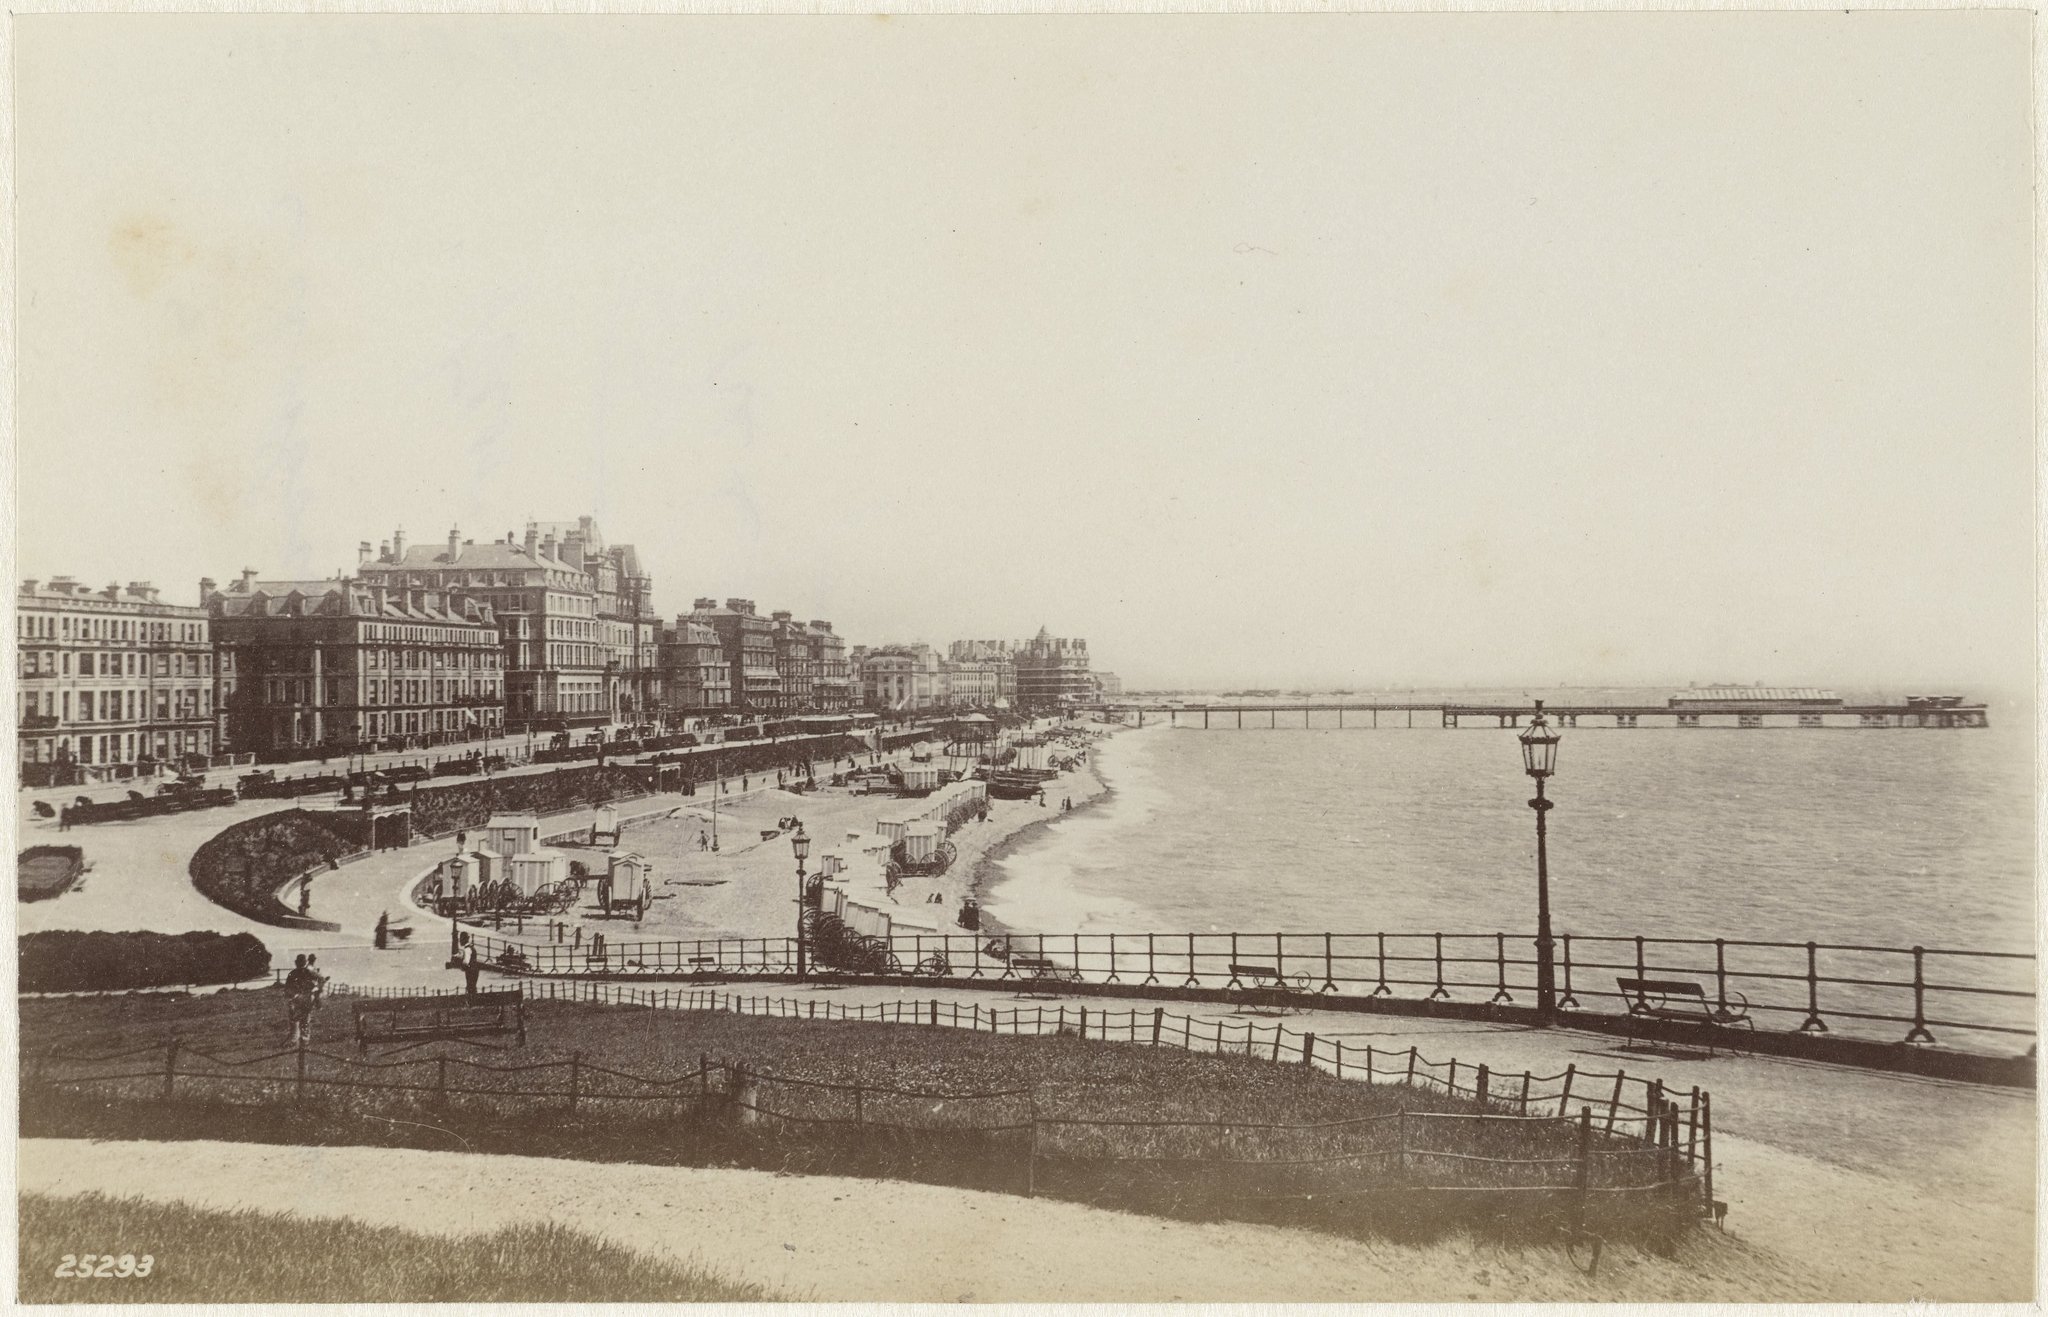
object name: photograph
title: Boulevard in Eastbourne, East Sussex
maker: Anonymous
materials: paper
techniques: albumen print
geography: eastbourne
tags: avenue, boulevard, promenade, esplanade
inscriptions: number: ‘25293’, inscription: ‘Eastbourne 14-16/4 1900/ [...] in summertime/ The Grand Parade’